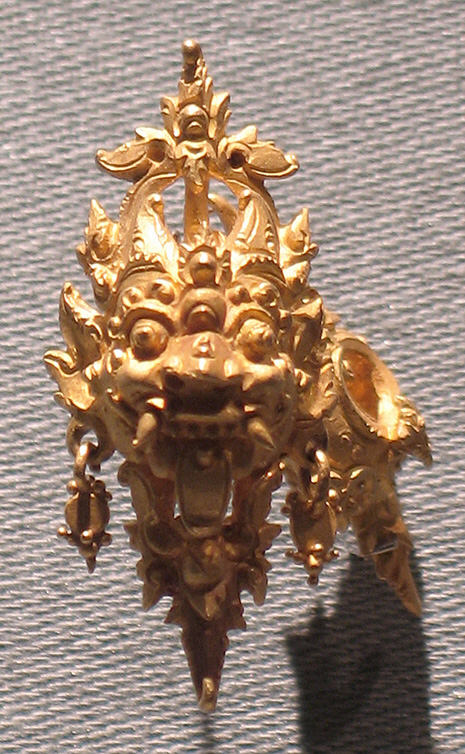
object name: ear ornament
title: Ear Ornament with Kala Motif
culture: indonesian, javanese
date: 801-1400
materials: gold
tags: deities